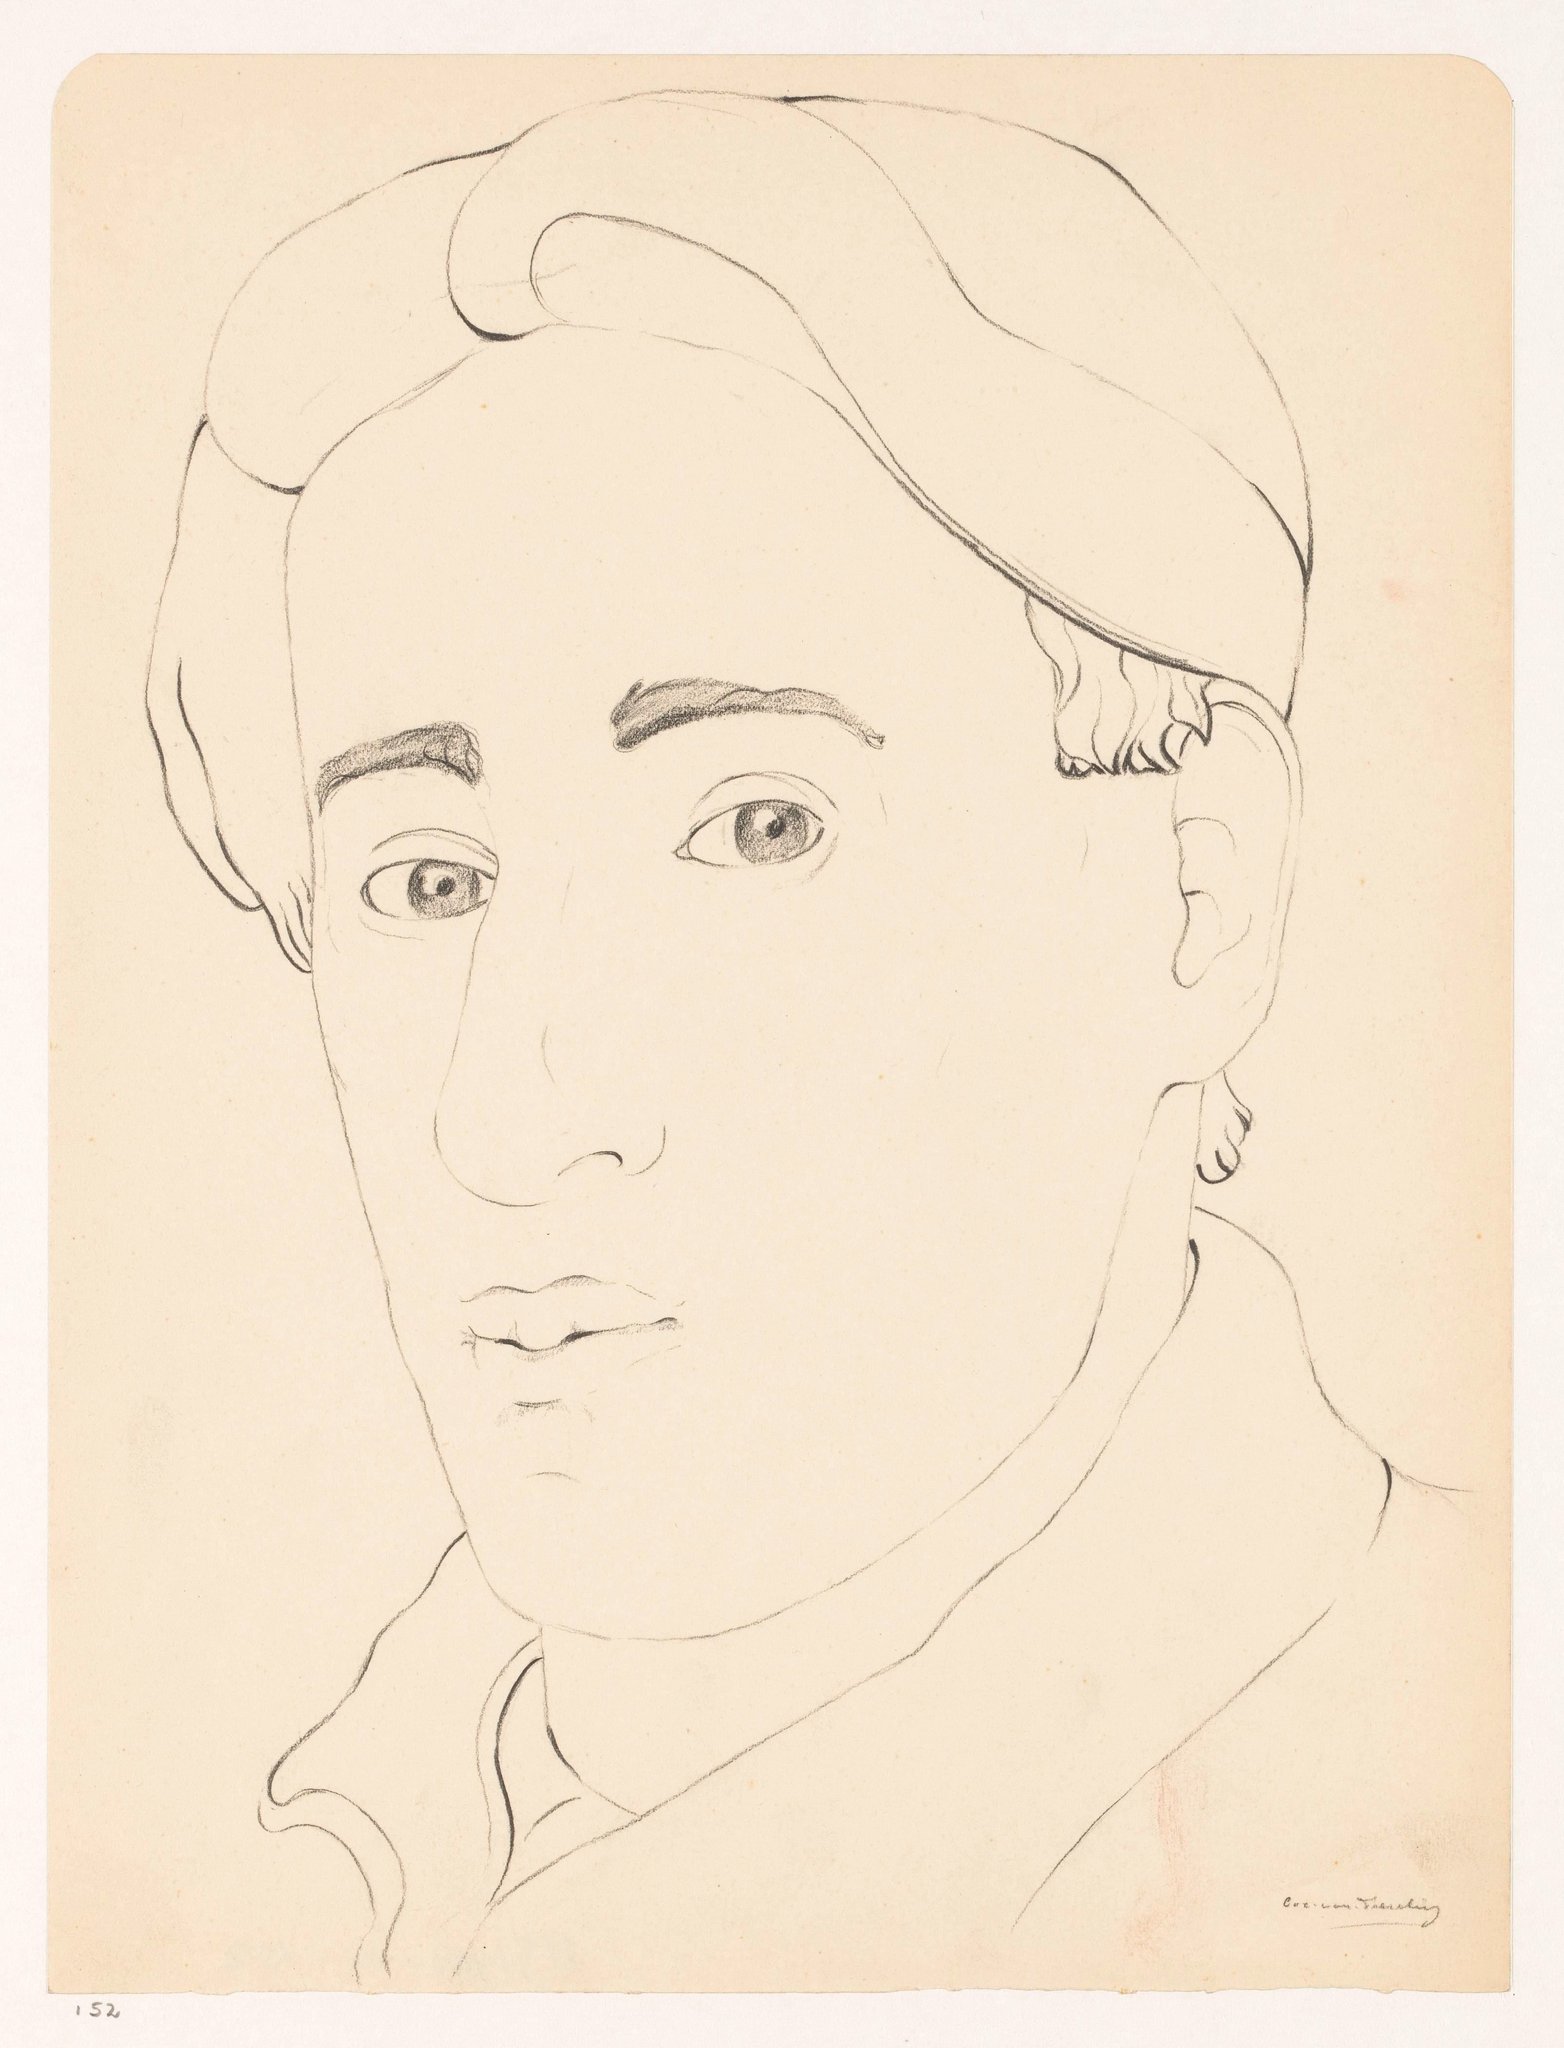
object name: drawing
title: Zelfportretten van Cor van Teeseling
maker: cor van teeseling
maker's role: draughtsman, sculptor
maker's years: 1915-1942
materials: chalk, paper, pencil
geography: amsterdam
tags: amsterdam, draughtsman, sculptor, cor van teeseling, historical persons, prisoner in cell or locked place, portrait, self-portrait of draughtsman, netherlands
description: Zelfportret van Cor van Teeseling, driekwart naar links gewend.